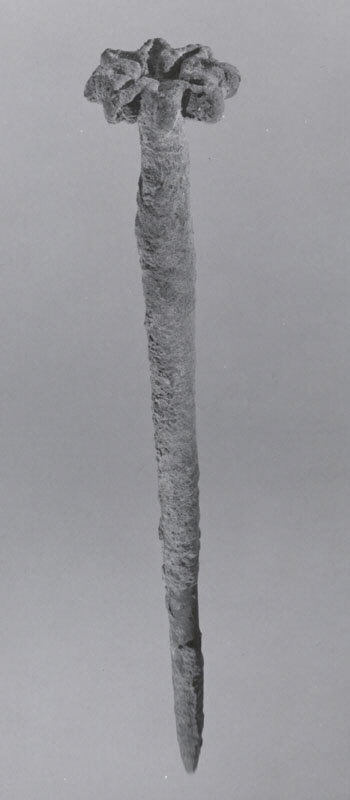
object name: pin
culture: bactria-margiana archaeological complex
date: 2333-1668 BCE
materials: copper alloy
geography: bactria-margiana